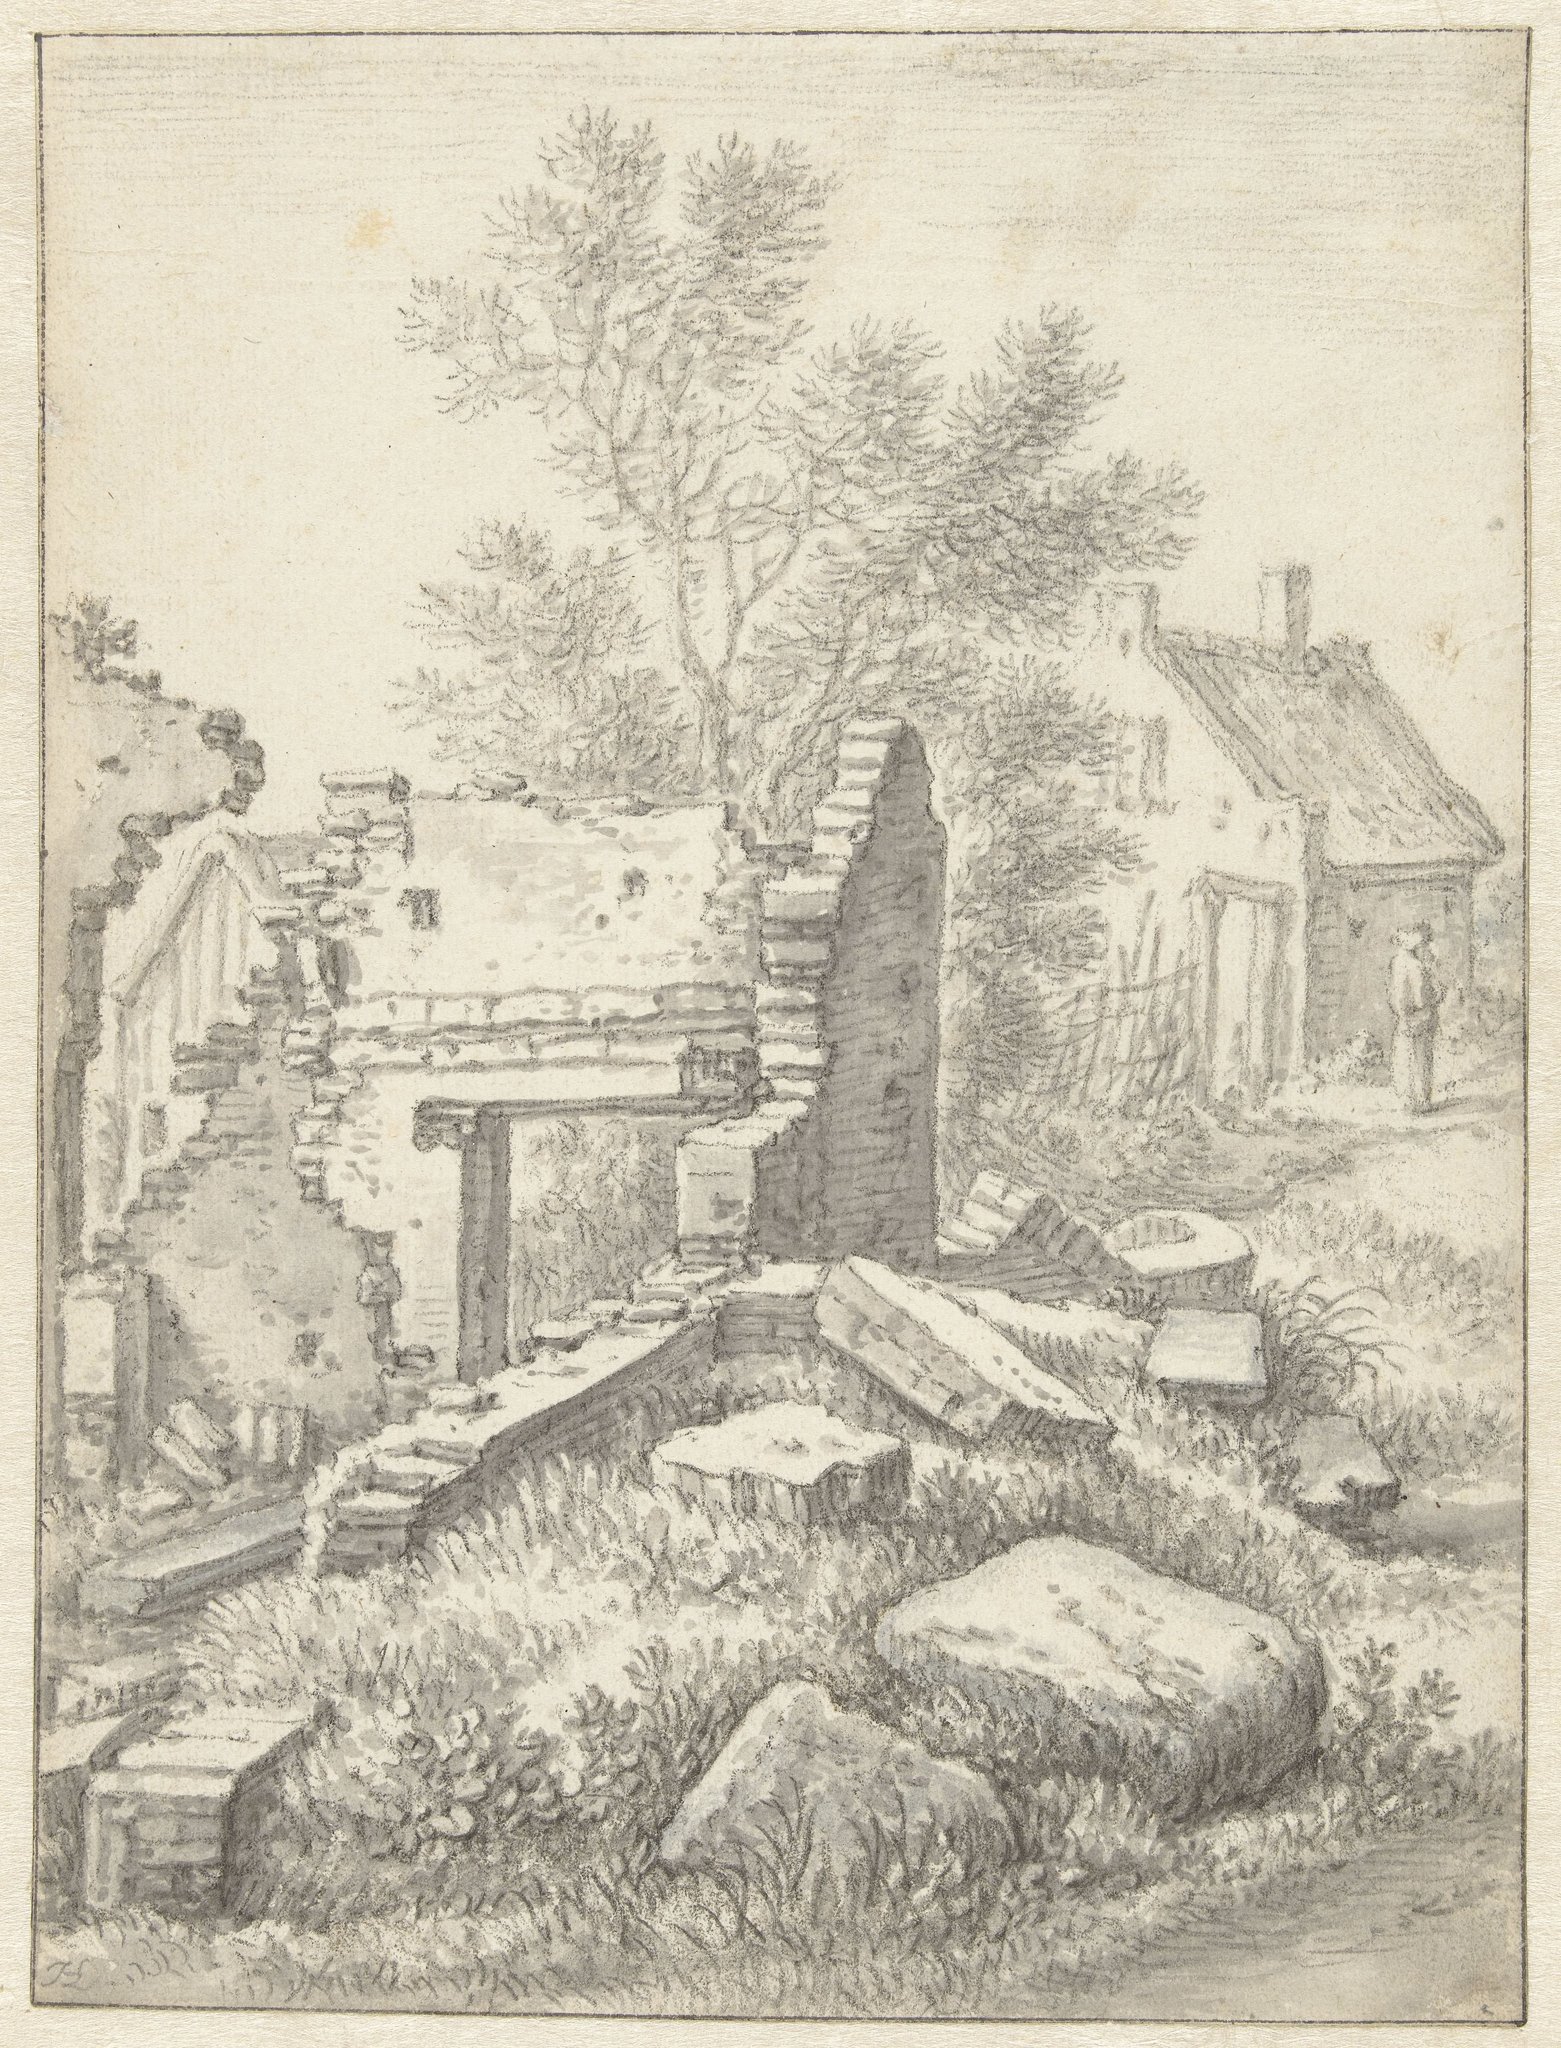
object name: drawing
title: Ruïnes van een huis in Utrecht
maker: herman saftleven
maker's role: draughtsman, painter, print maker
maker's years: 1609-1685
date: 1674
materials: chalk, paper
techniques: brush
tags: urban housing, ruin of a building ~ architecture, utrecht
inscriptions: : ‘Dit op dander syde getekent van Herman Saftleven is buitte de Catrinapoort ao 1674’, date: ‘1674’